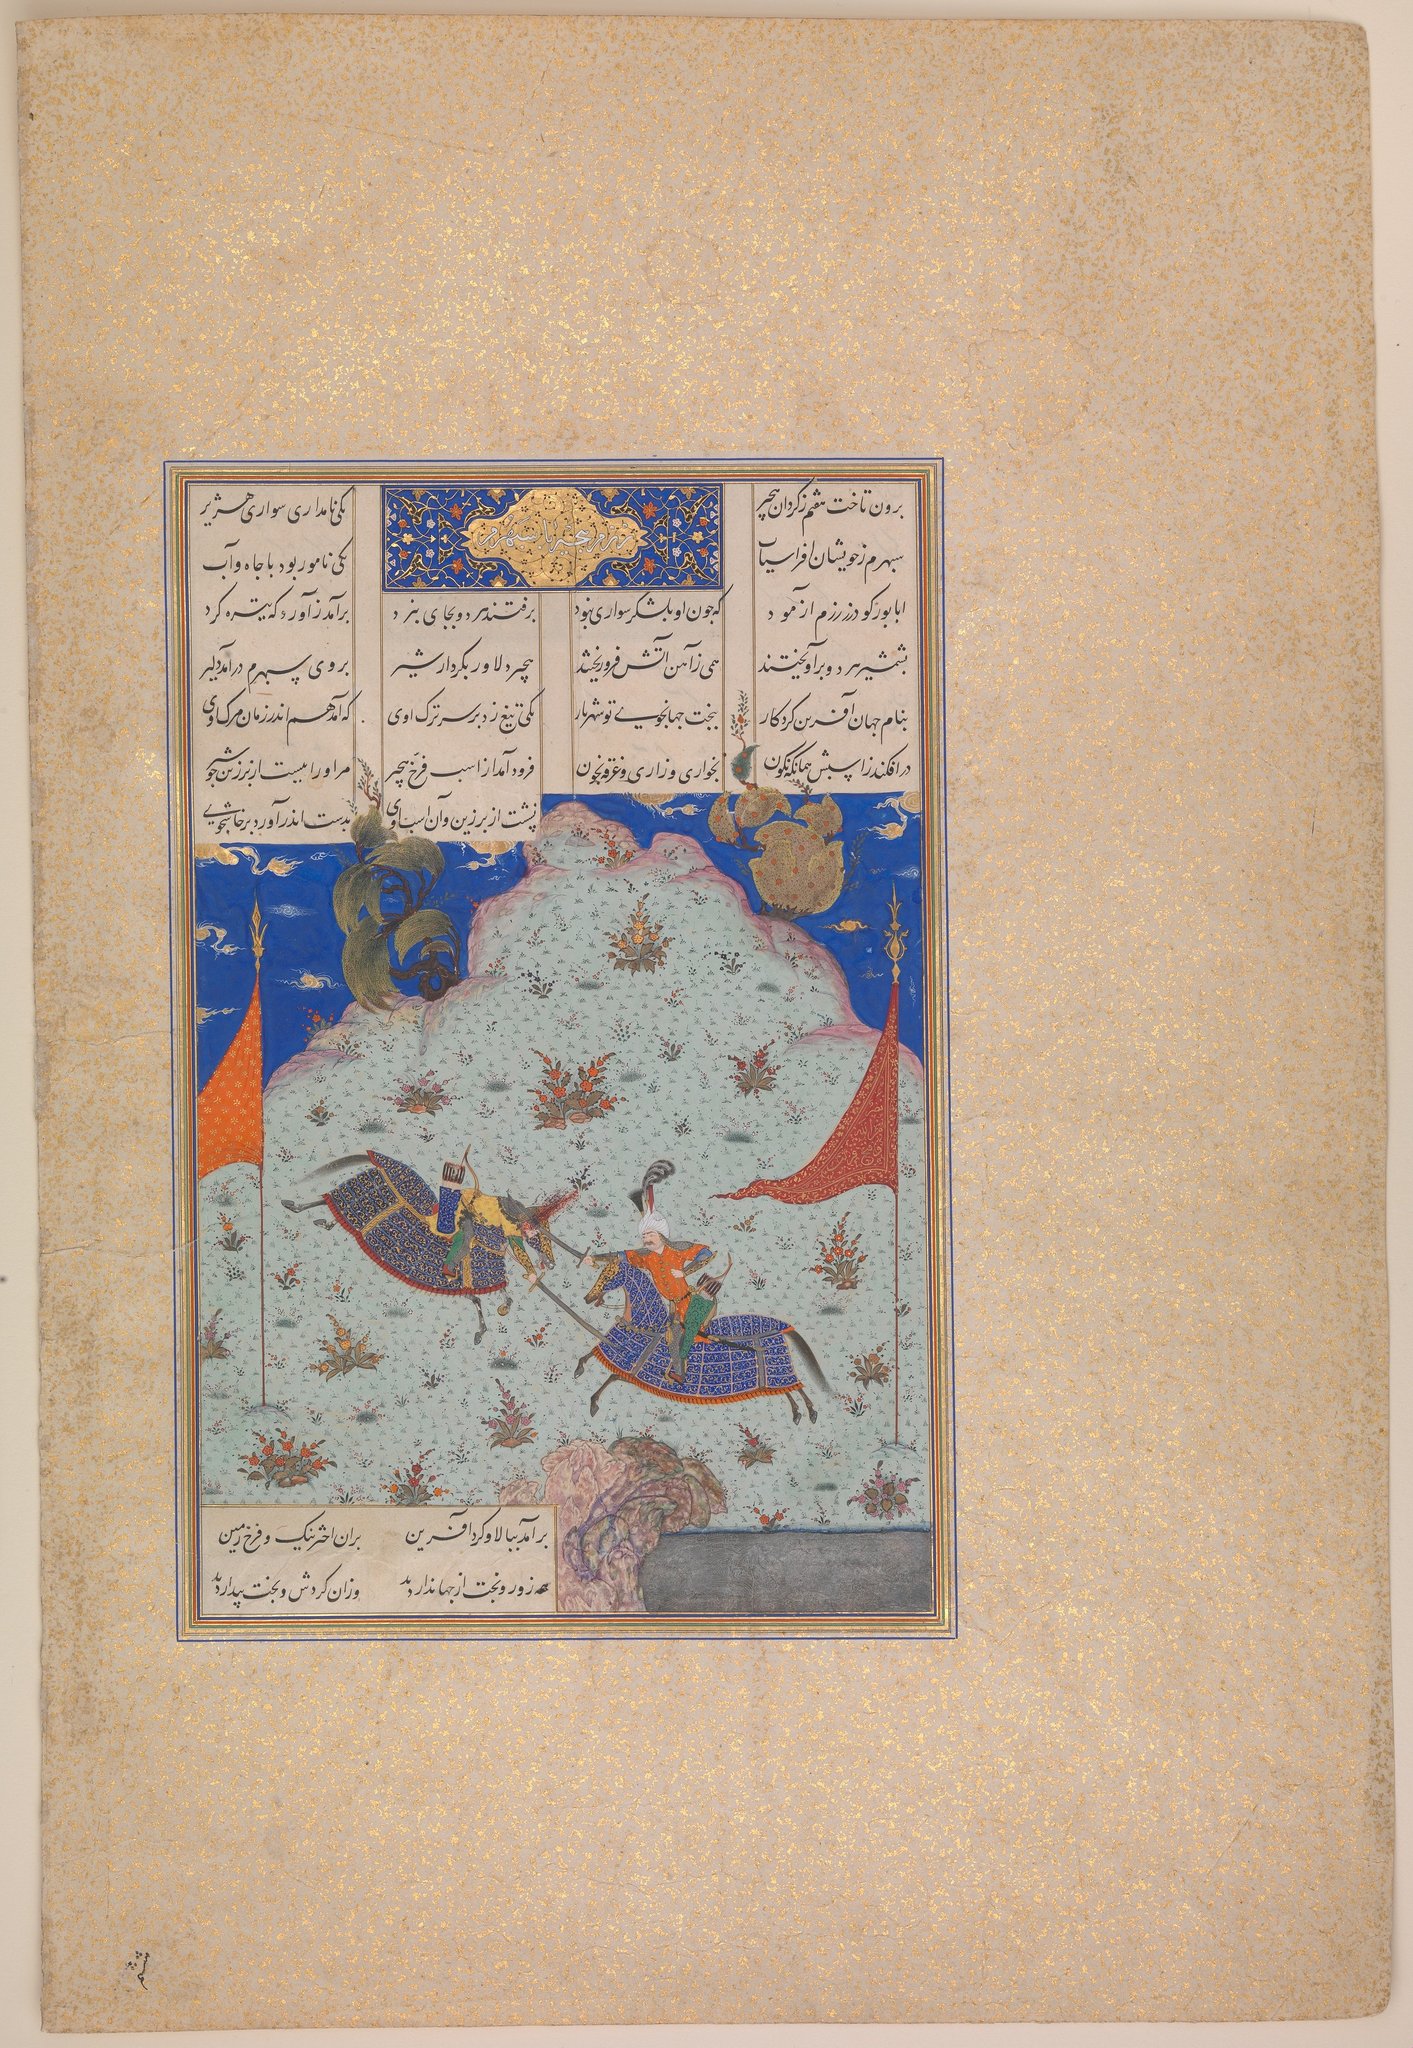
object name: folio from an illustrated manuscript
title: "The Sixth Joust of the Rooks: Bizhan Versus Ruyyin", Folio 343r from the Shahnama (Book of Kings) of Shah Tahmasp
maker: abu'l qasim firdausi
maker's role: author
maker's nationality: iranian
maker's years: 935-1020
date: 1525-1530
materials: gold, ink, paper, silver, watercolor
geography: iran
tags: bow and arrow,swords,men,horses